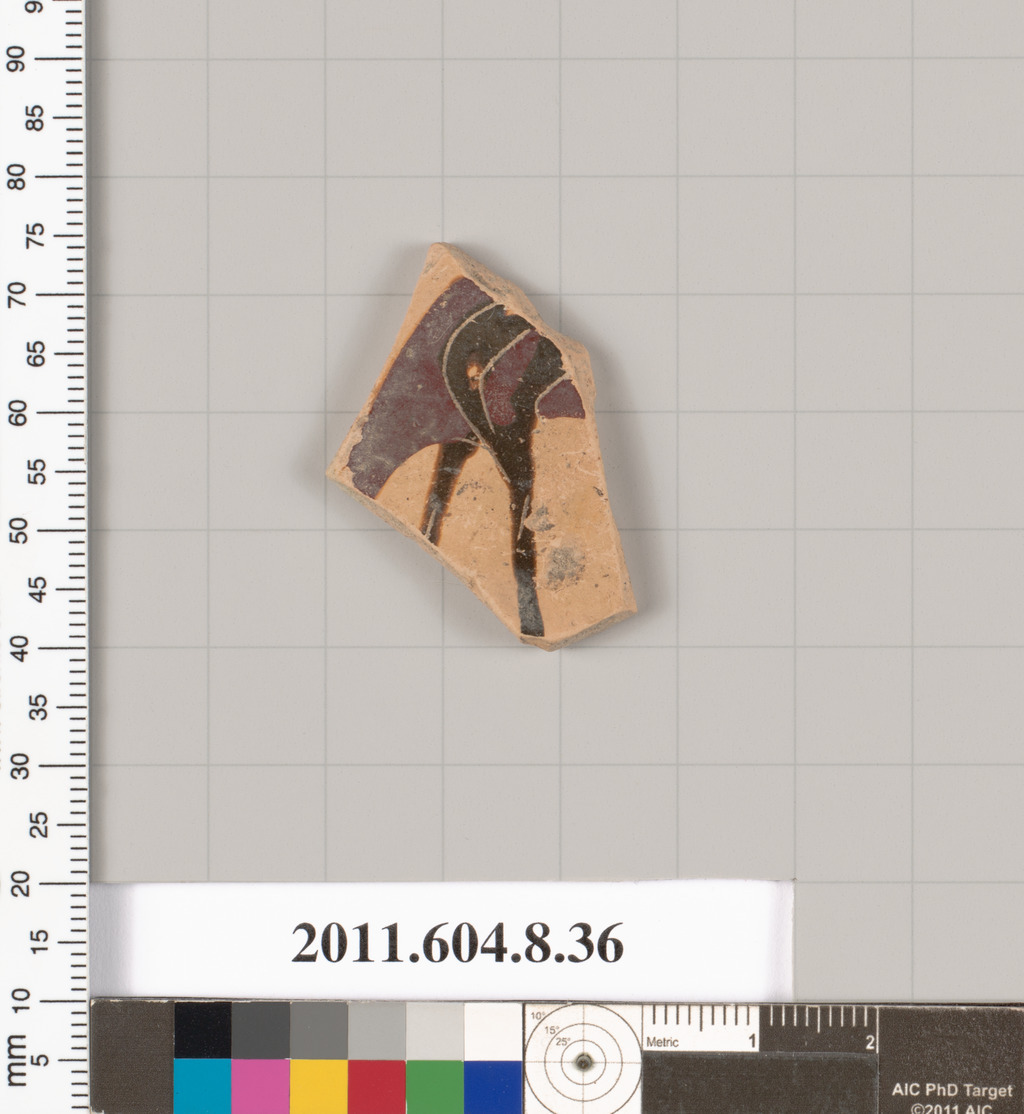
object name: undetermined closed shape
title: Terracotta fragment of a closed shape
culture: greek, corinthian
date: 600-501 BCE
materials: terracotta